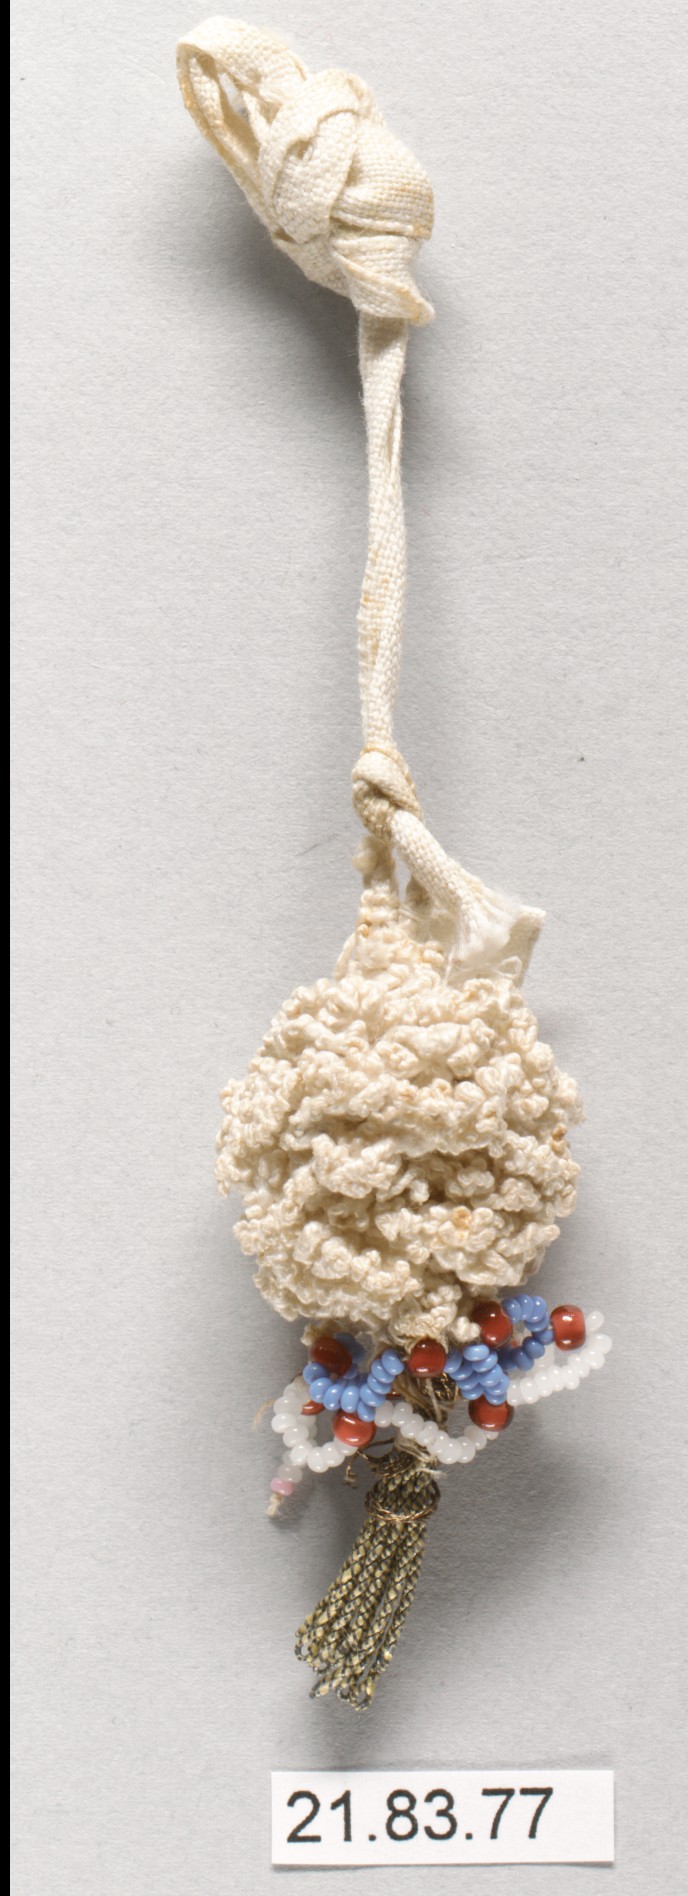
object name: tassel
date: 1601-1700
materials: linen, metal thread